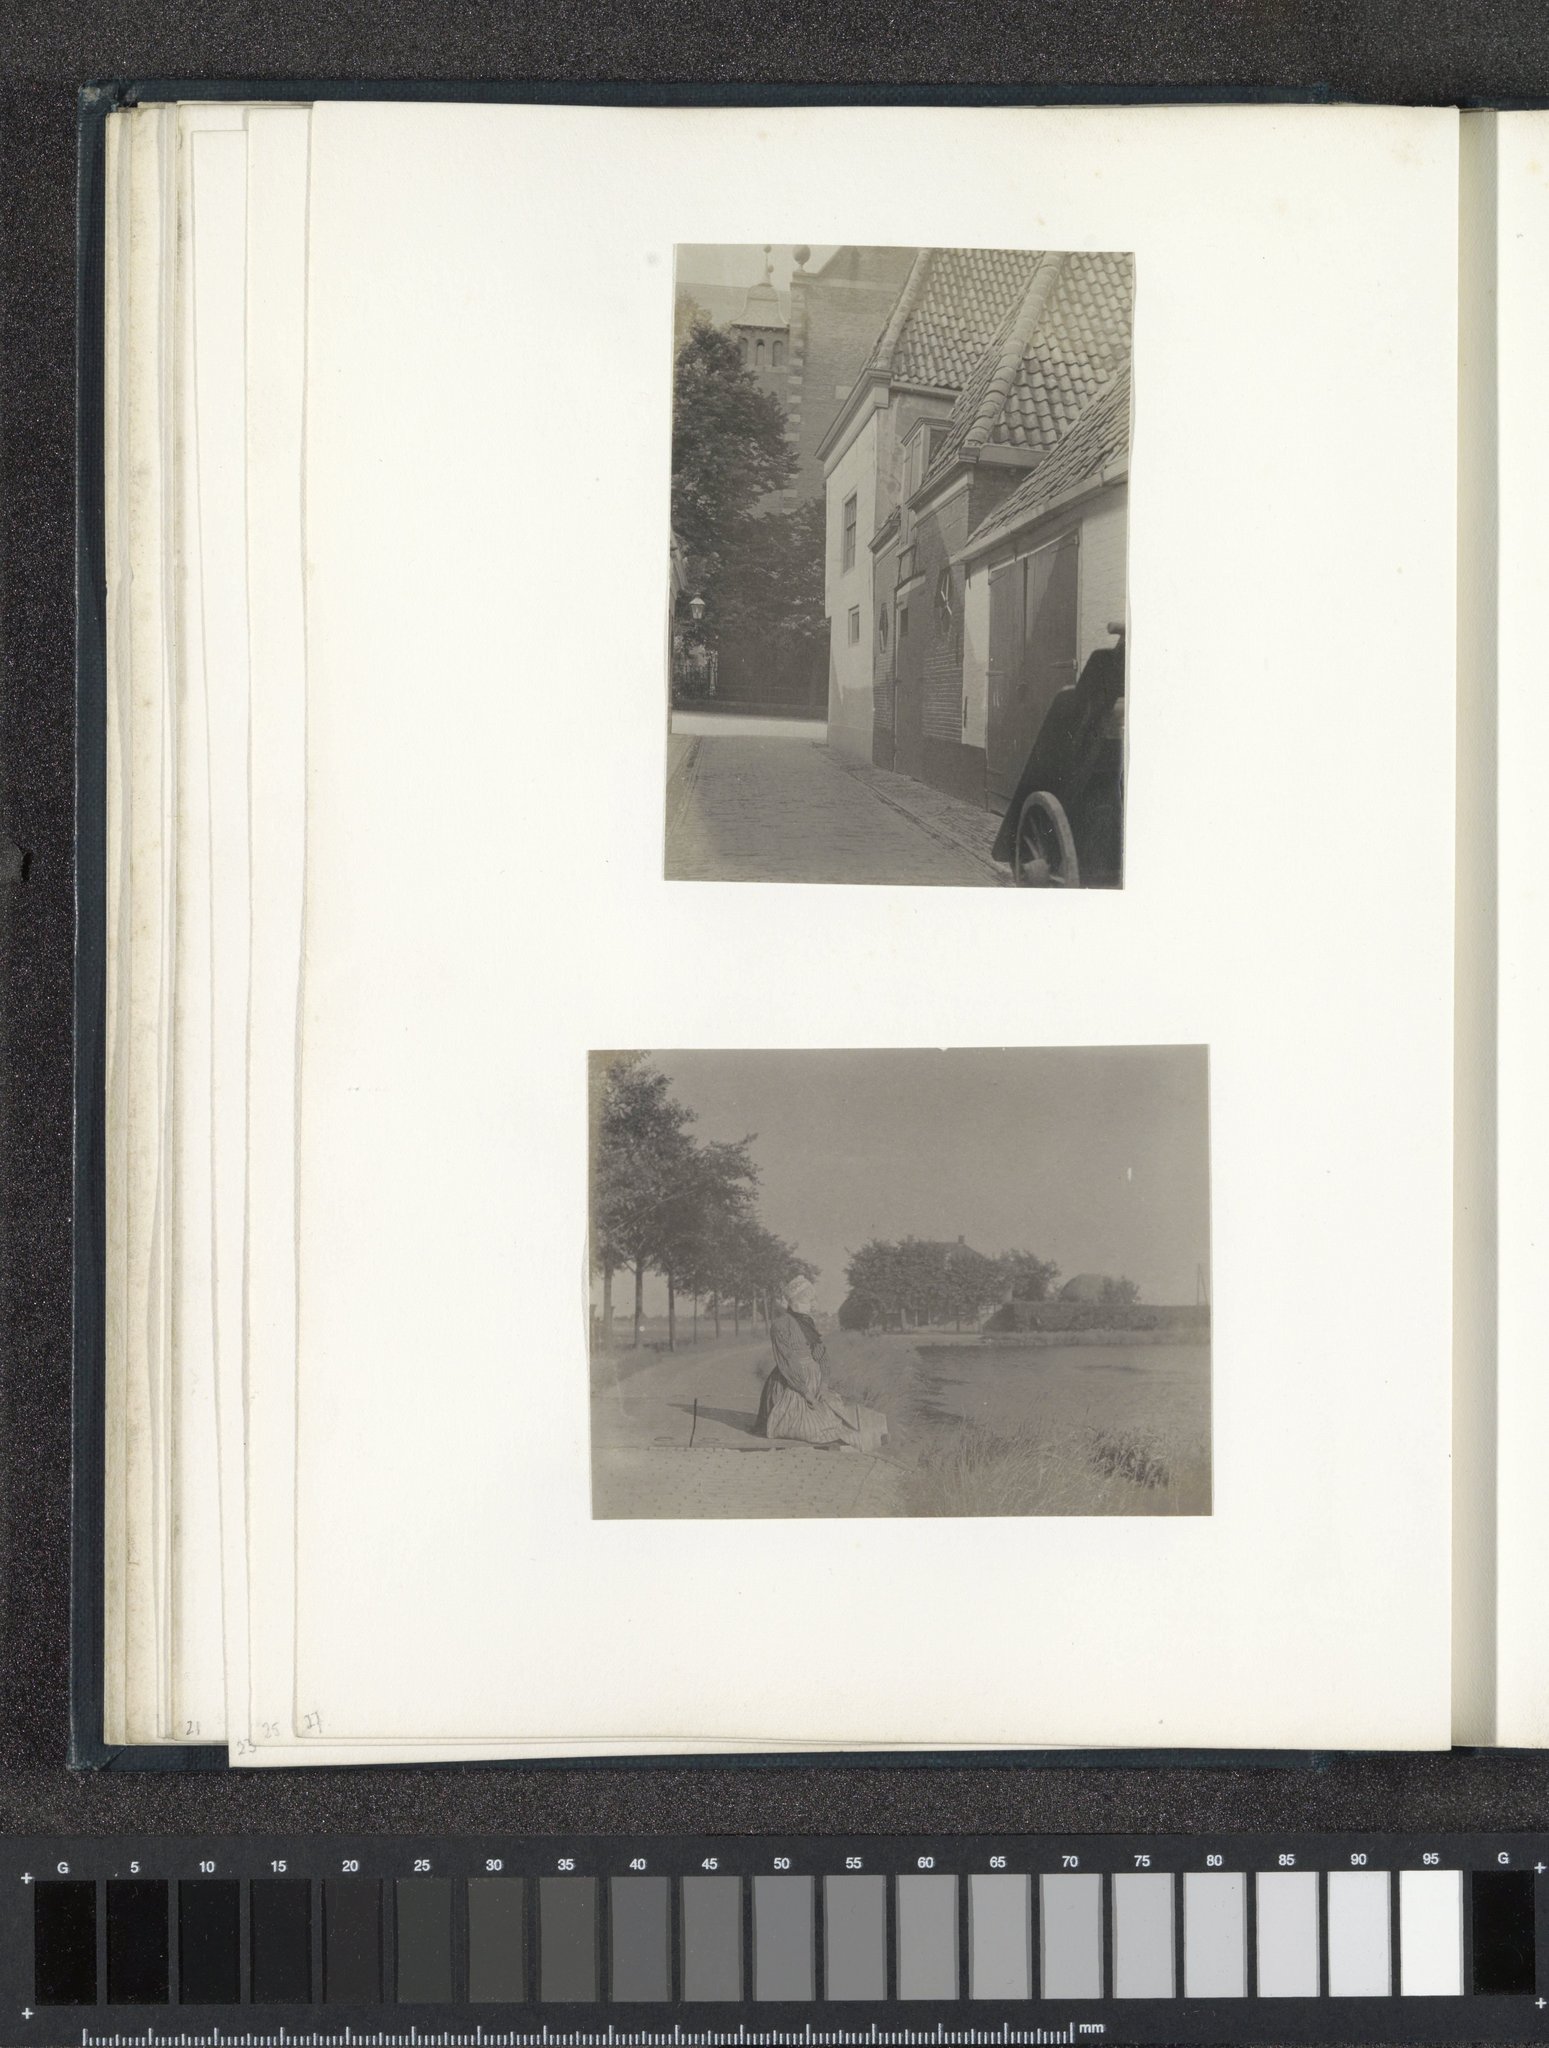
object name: photograph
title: Gezicht op de Pieterseliesteeg te Hoorn, gezien naar het Kerkplein met de Grote Kerk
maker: george hidderley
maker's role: fotograaf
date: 1900-1910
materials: paper, photographic support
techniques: gelatin silver print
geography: hoorn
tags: lane, alley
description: Onderdeel van fotoalbum met opnames van Volendam, Dordrecht, Gorinchem en Woudrichem.